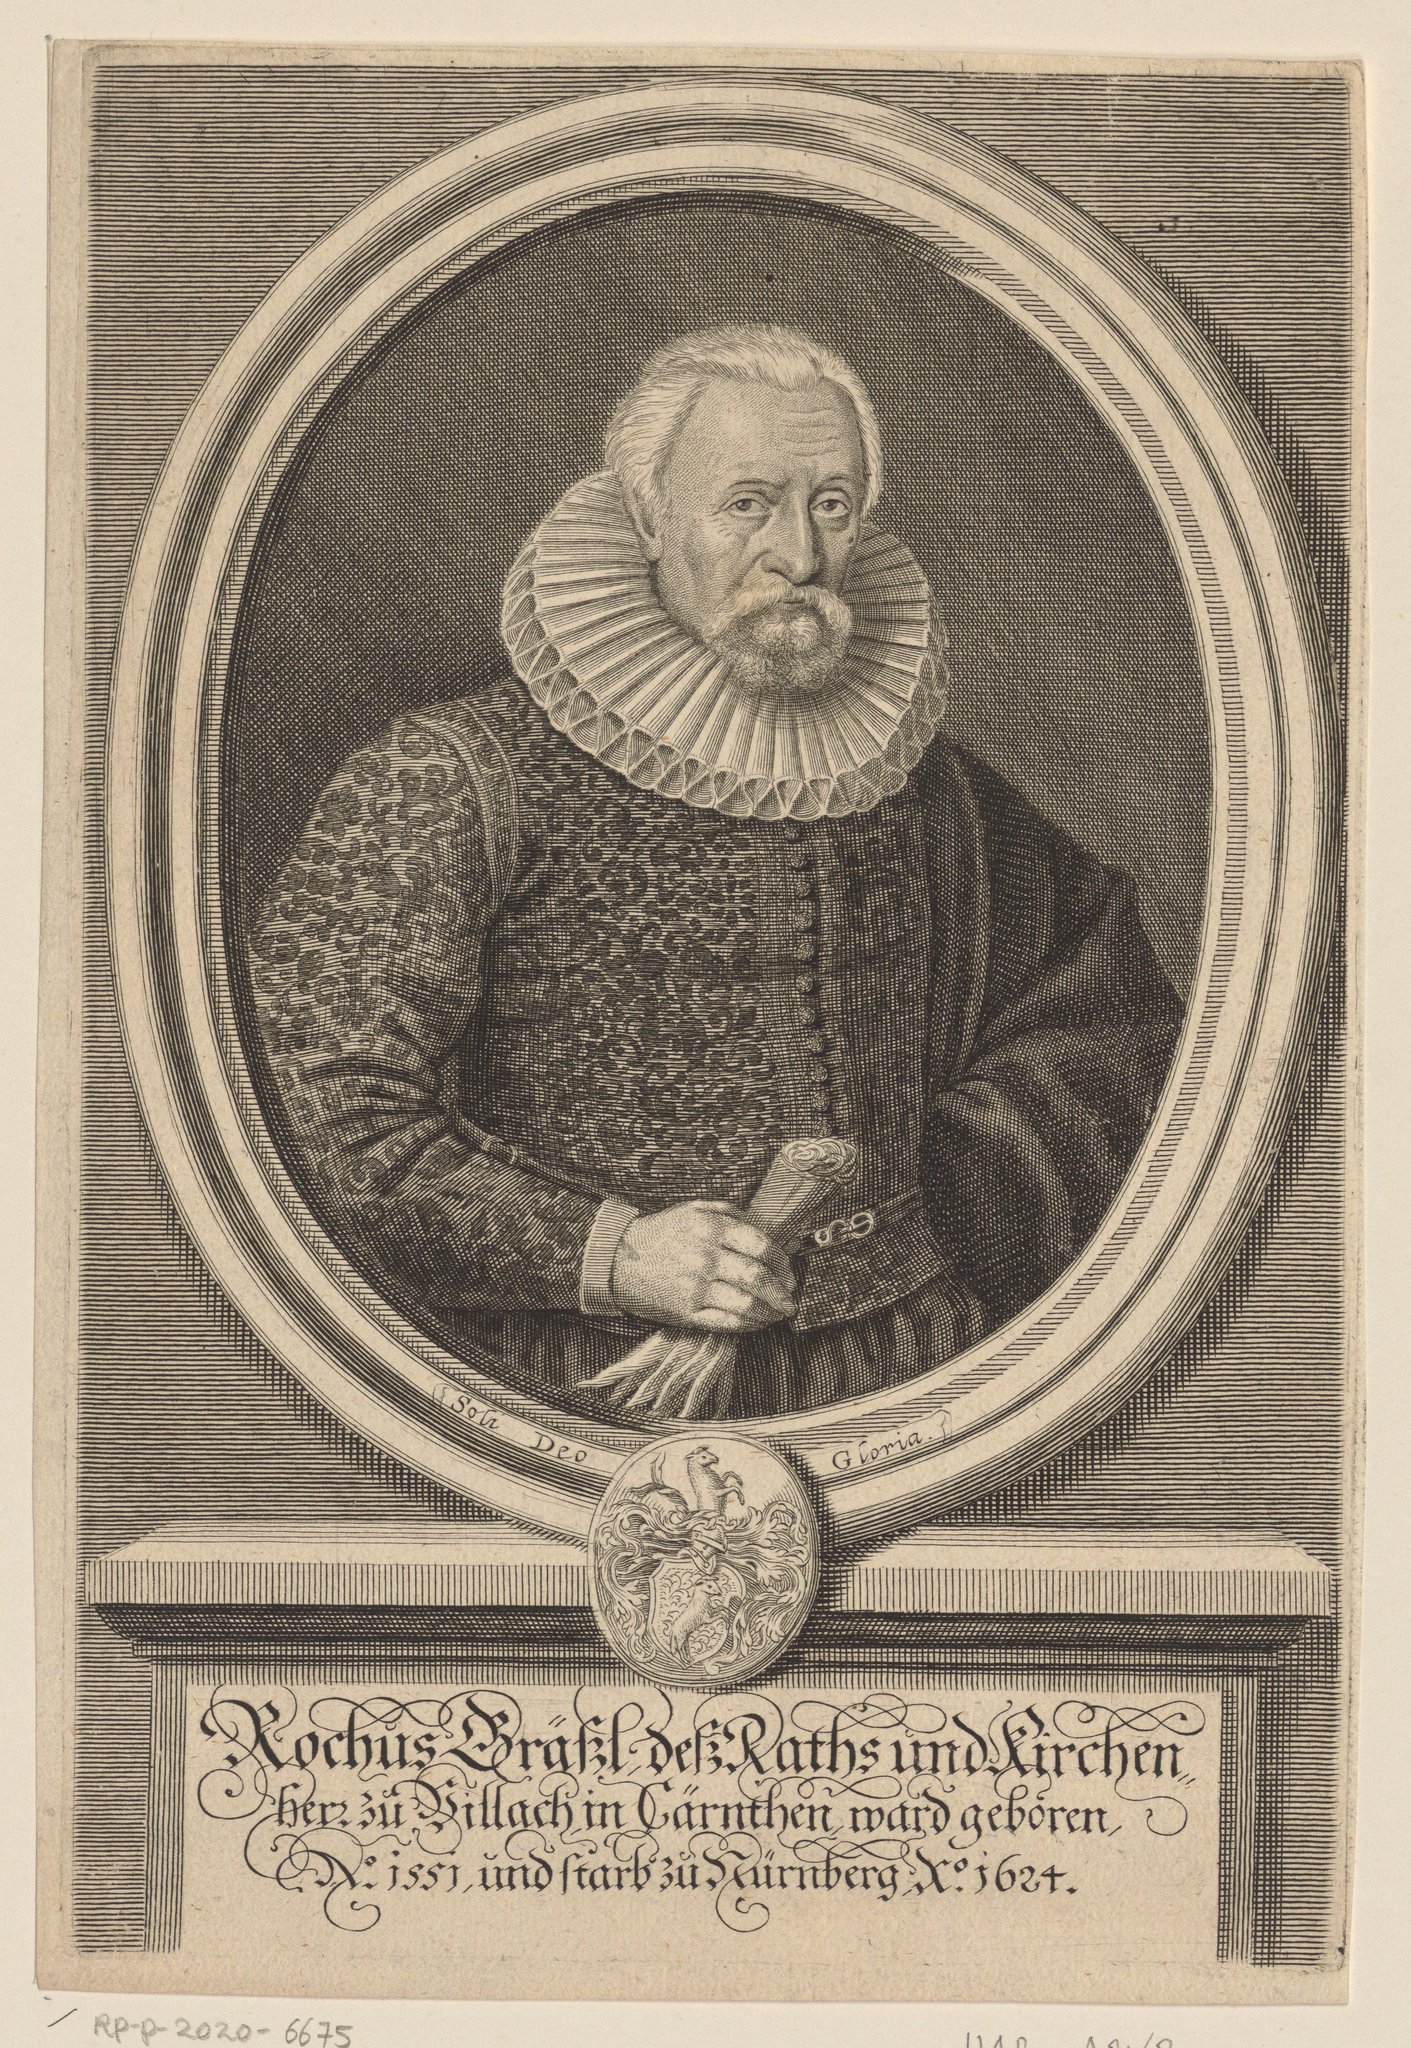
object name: print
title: Portret van Rochus Grässl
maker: Anonymous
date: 1624-1724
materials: paper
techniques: engraving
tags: historical persons, politician, e.g. party leader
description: Tekst in het Latijn in de ondermarge en in de omlijsting.